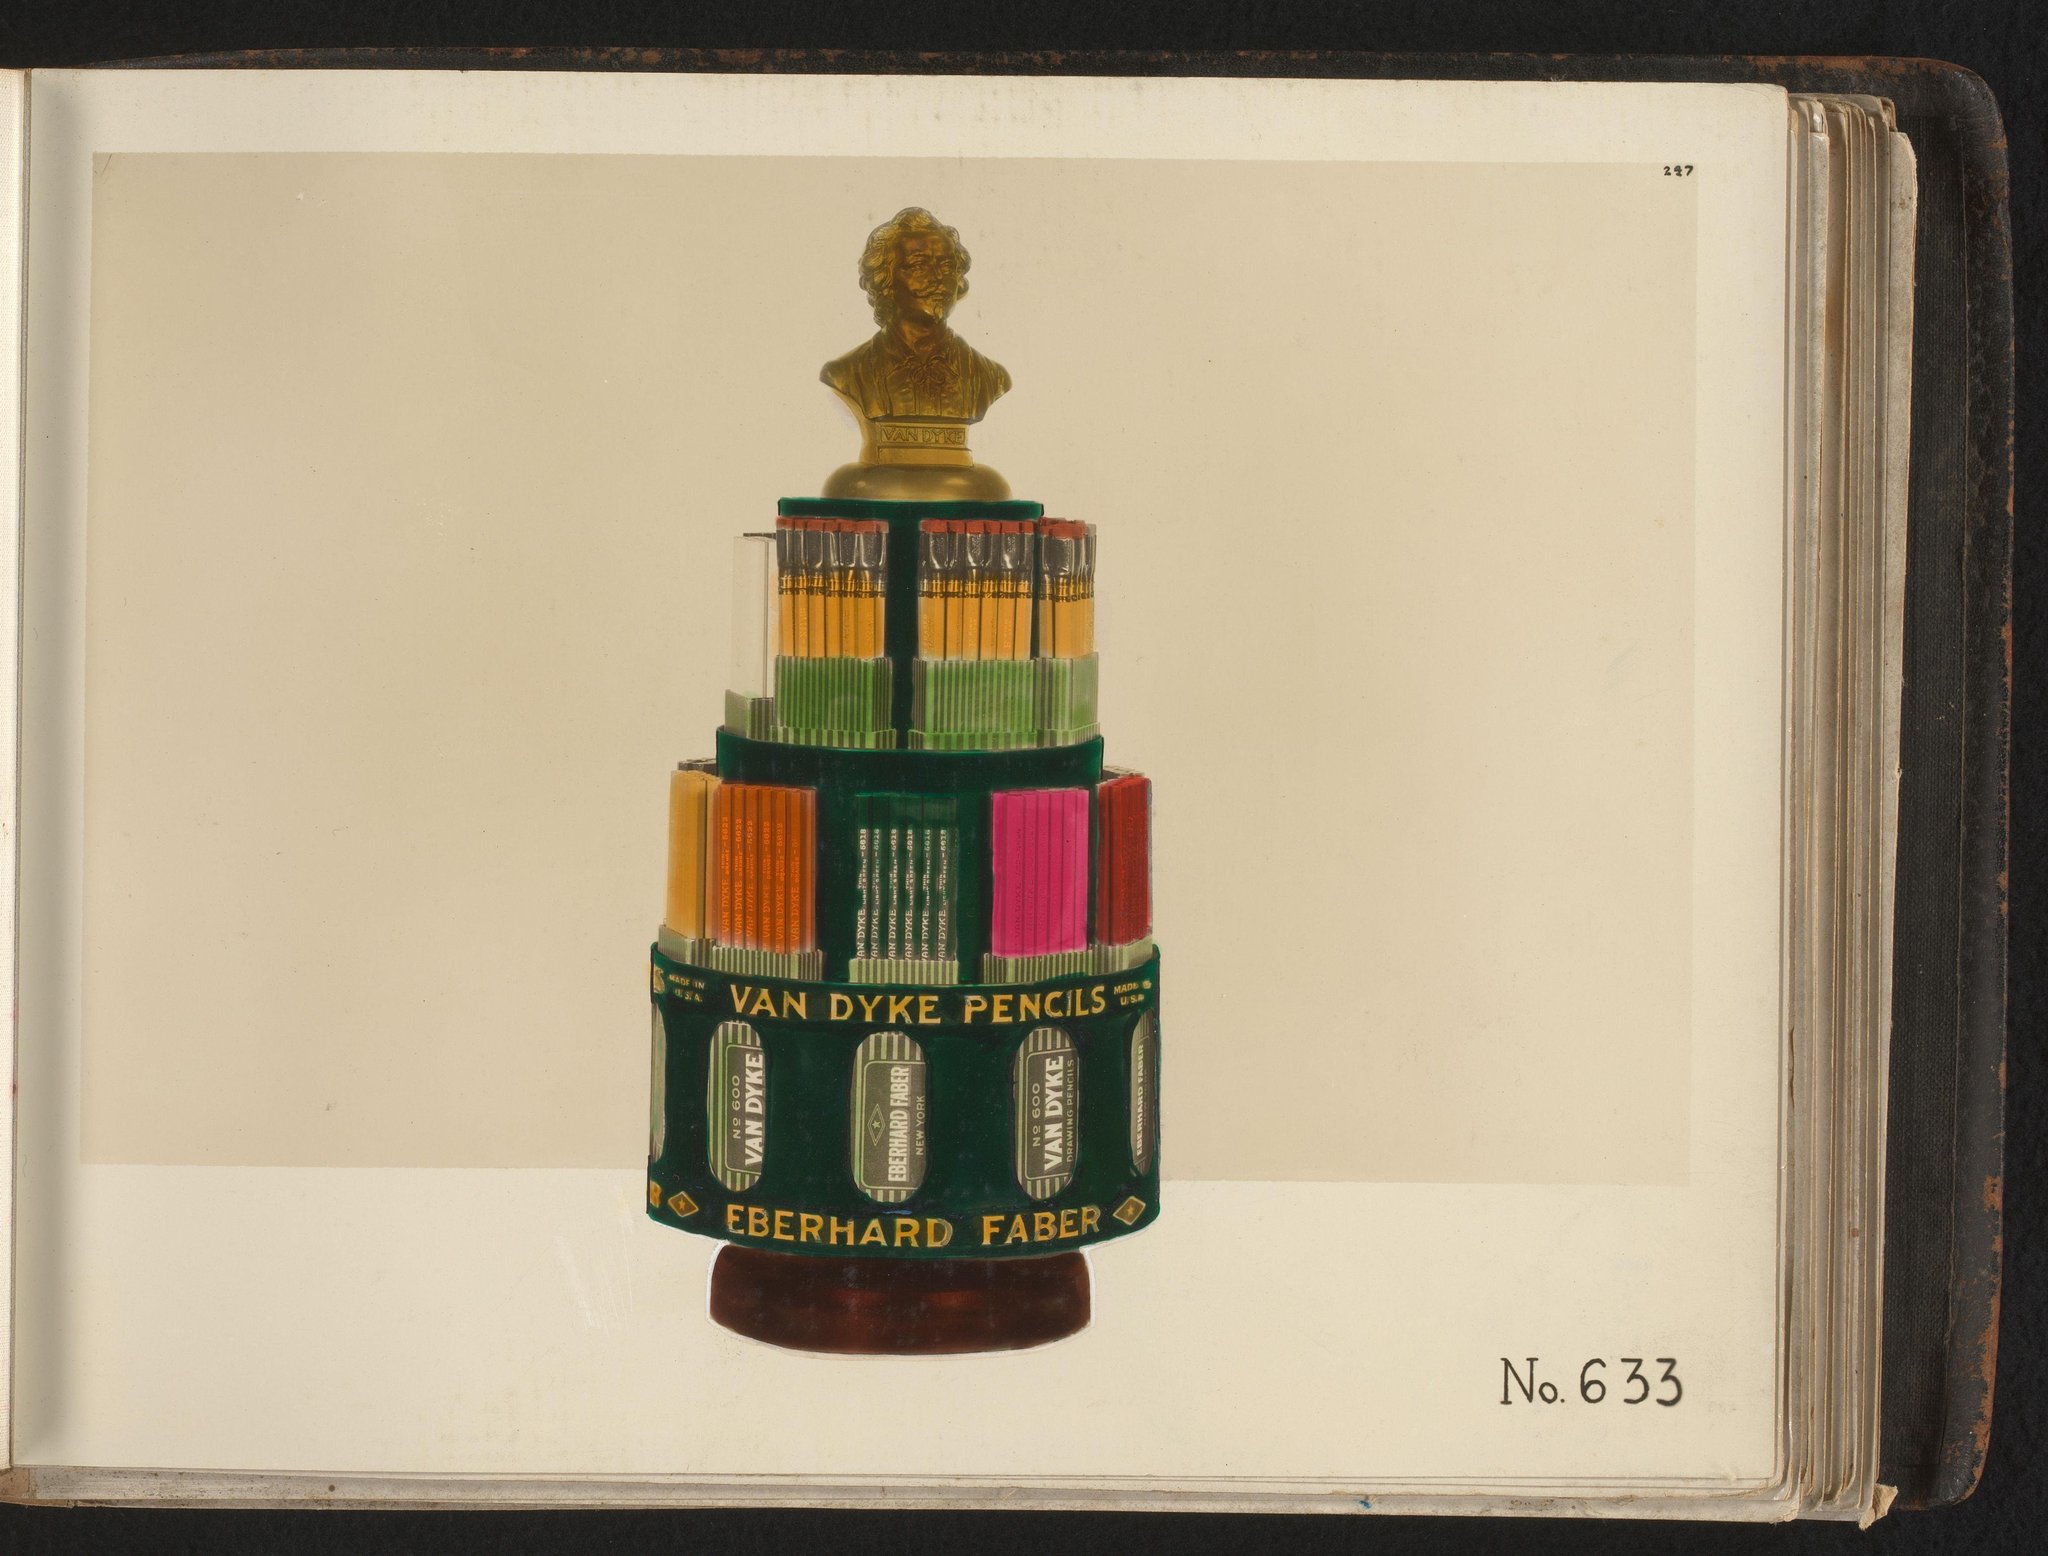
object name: album leaf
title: Standaard met potloden van Eberhard Faber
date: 1915-1935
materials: paper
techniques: gelatin silver print, hand coloring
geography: springfield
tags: pencil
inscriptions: number: ‘247’, stamp: ‘Paramount/ Commercial Studios/ 145 Chestnut St./ Springfield - Mass.’